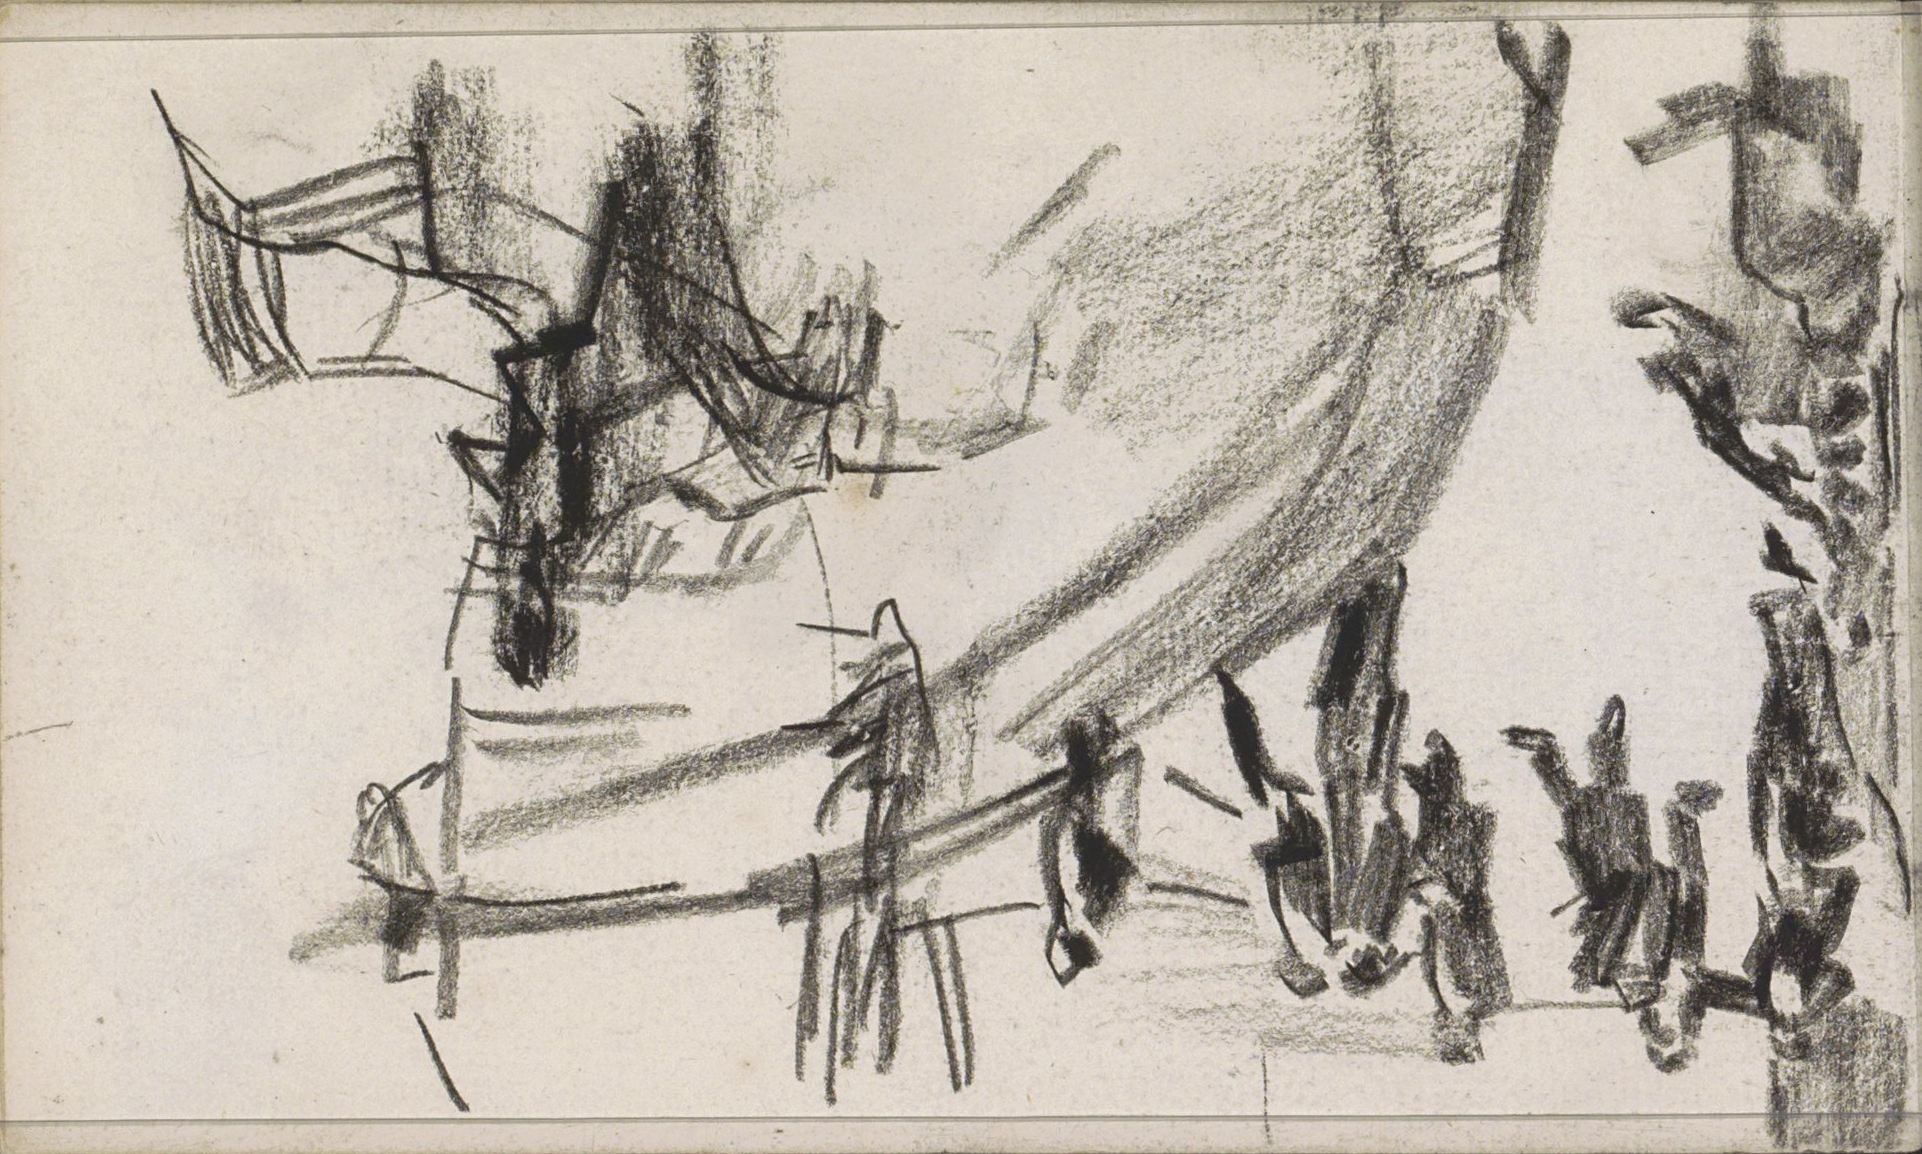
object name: sketchbook leaf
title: Man te paard voor toeschouwers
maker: isaac israels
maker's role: draughtsman, painter, print maker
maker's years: 1865-1934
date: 1875-1934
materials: chalk, paper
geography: the hague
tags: riding a horse, ass, or mule; rider, horseman, the audience ~ art performance, circus ring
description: Mogelijk in een circuspiste. Pagina 58 uit schetsboek XLVIII met 62 pagina's.